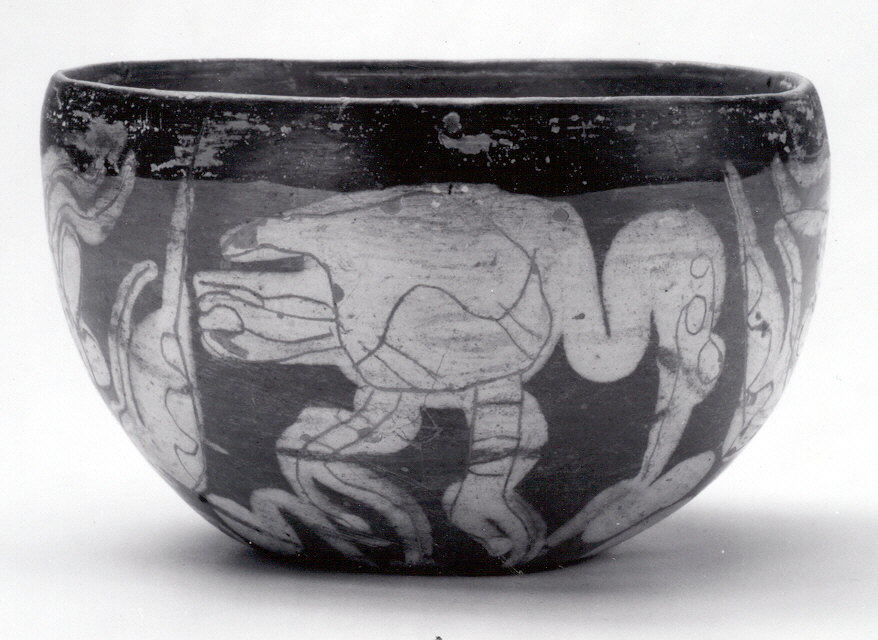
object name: bowl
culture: nopiloa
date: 601-1000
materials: ceramic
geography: mexico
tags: birds